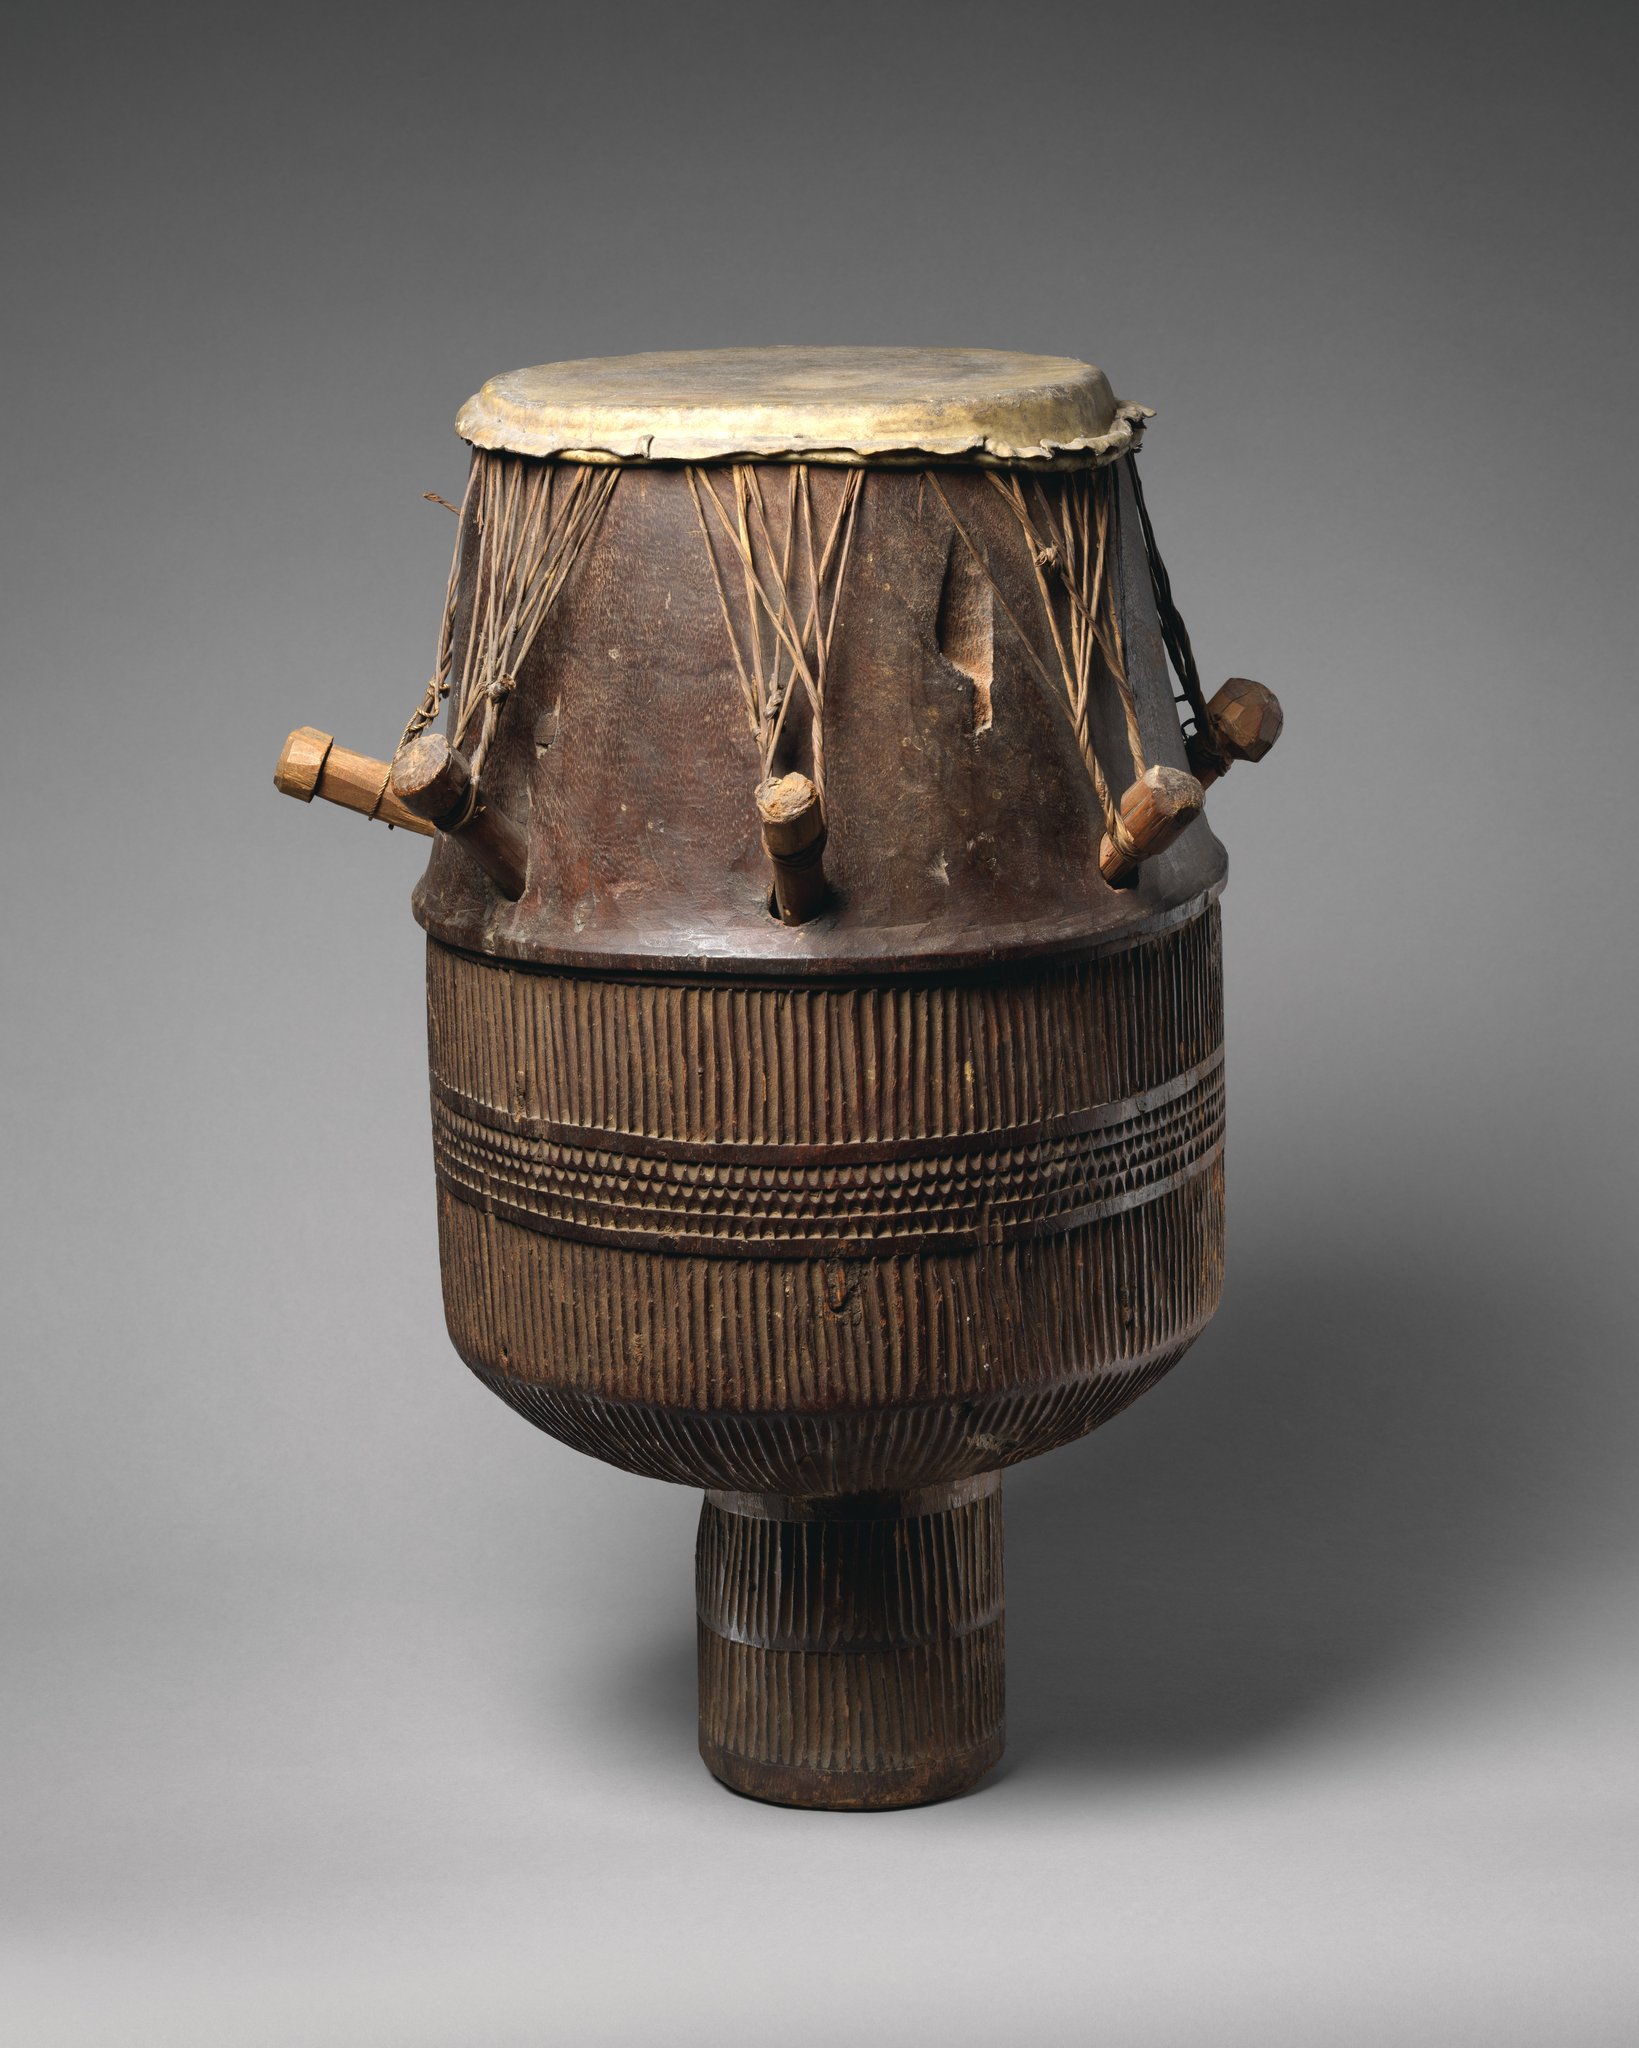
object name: atumpan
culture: ashanti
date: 1801-1900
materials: fiber, wood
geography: ghana